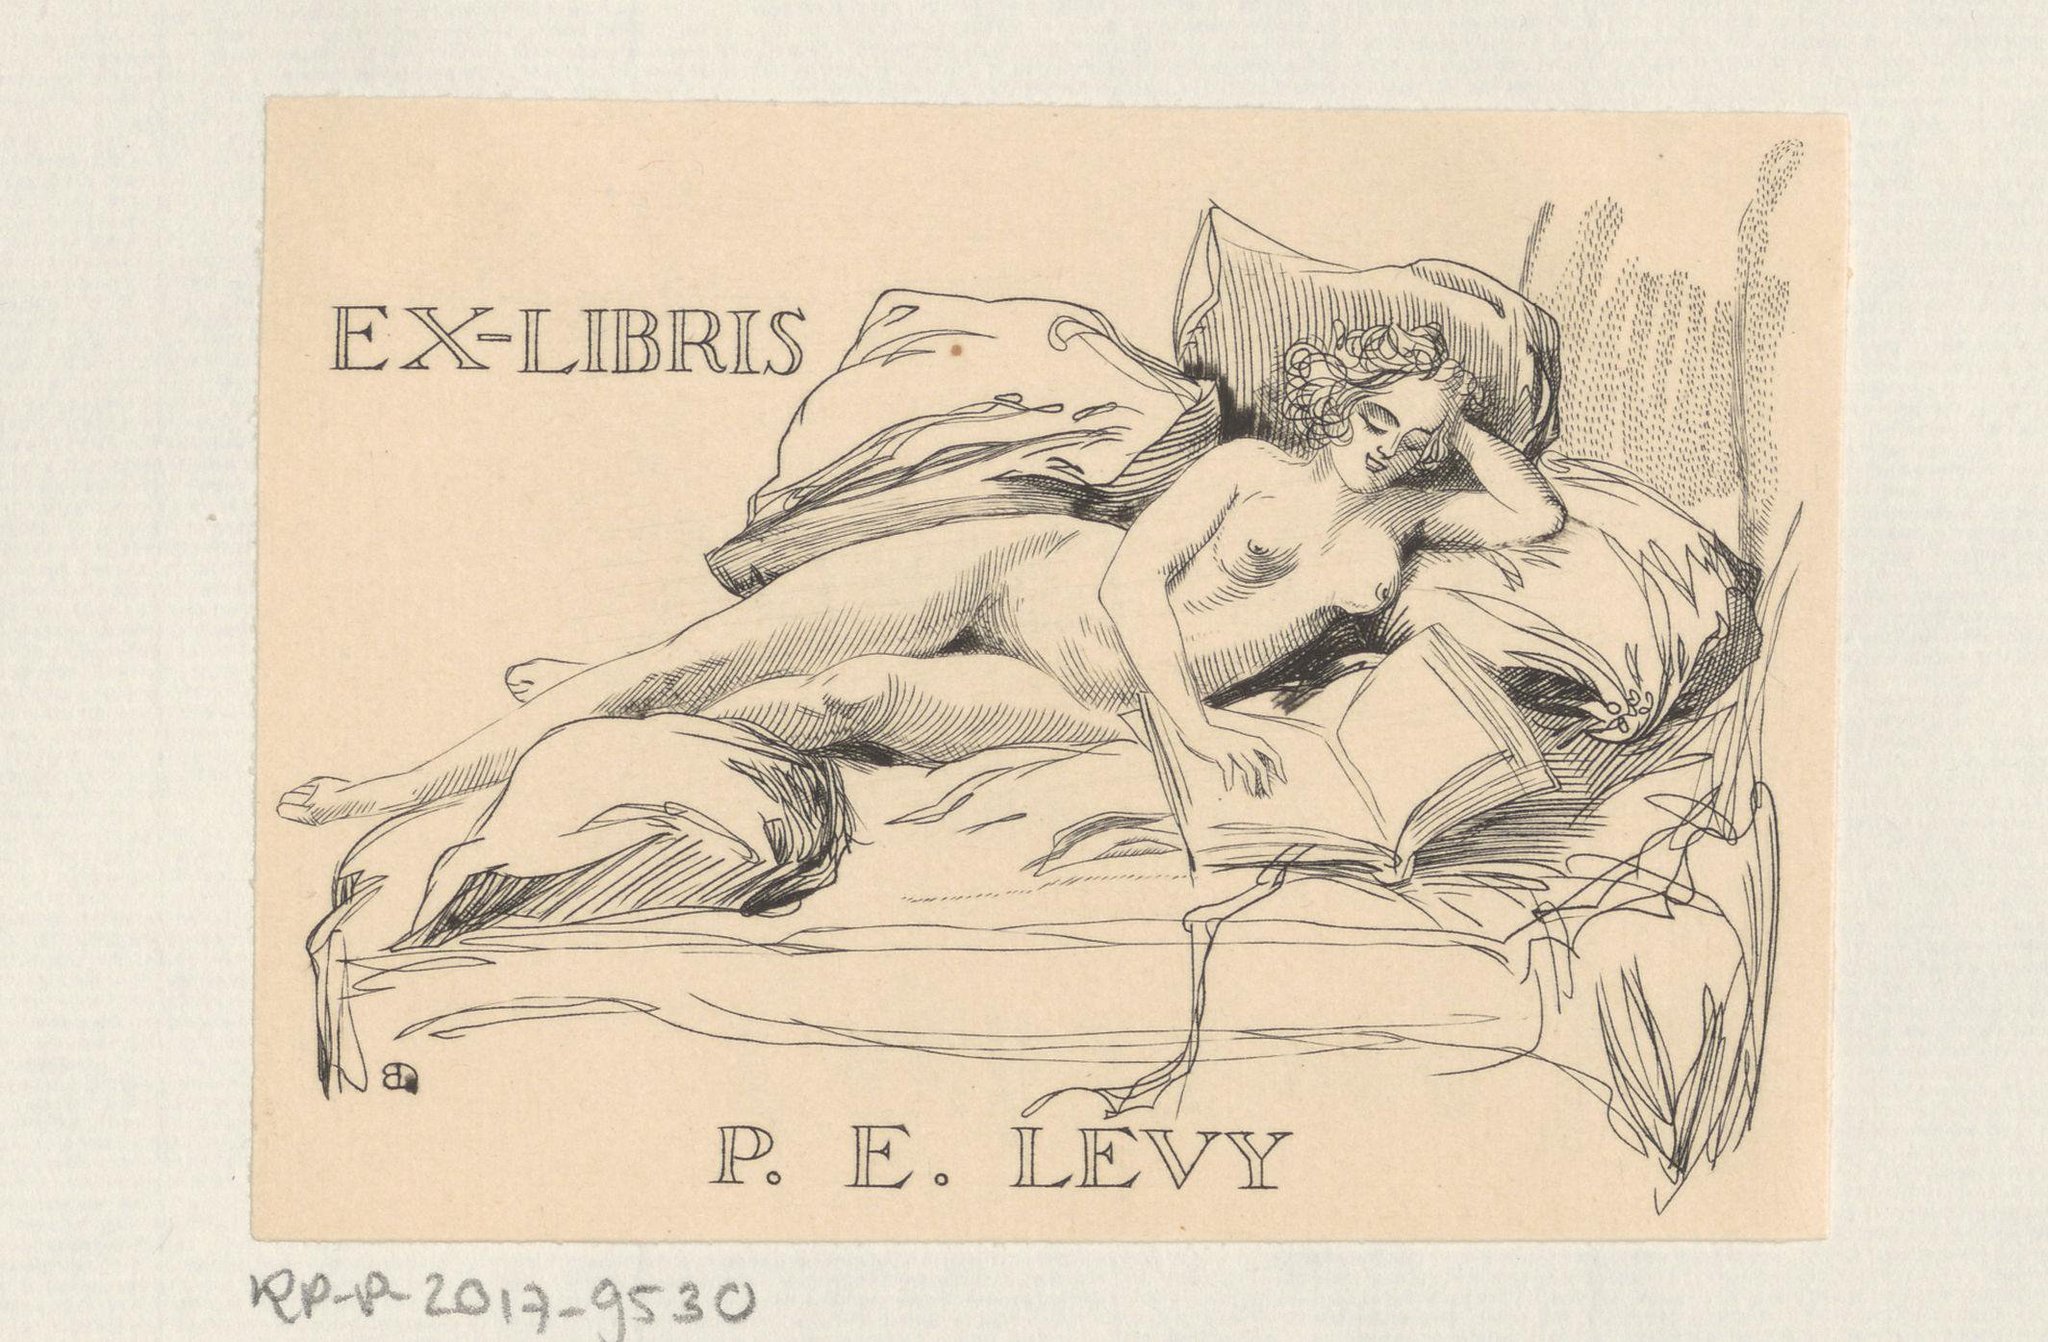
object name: bookplate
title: Ex libris van Pierre Edmond Lévy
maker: c.l. brossé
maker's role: print maker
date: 1920-1969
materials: paper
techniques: etching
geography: paris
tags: reading, woman (showing herself) undressed, quasi-nude